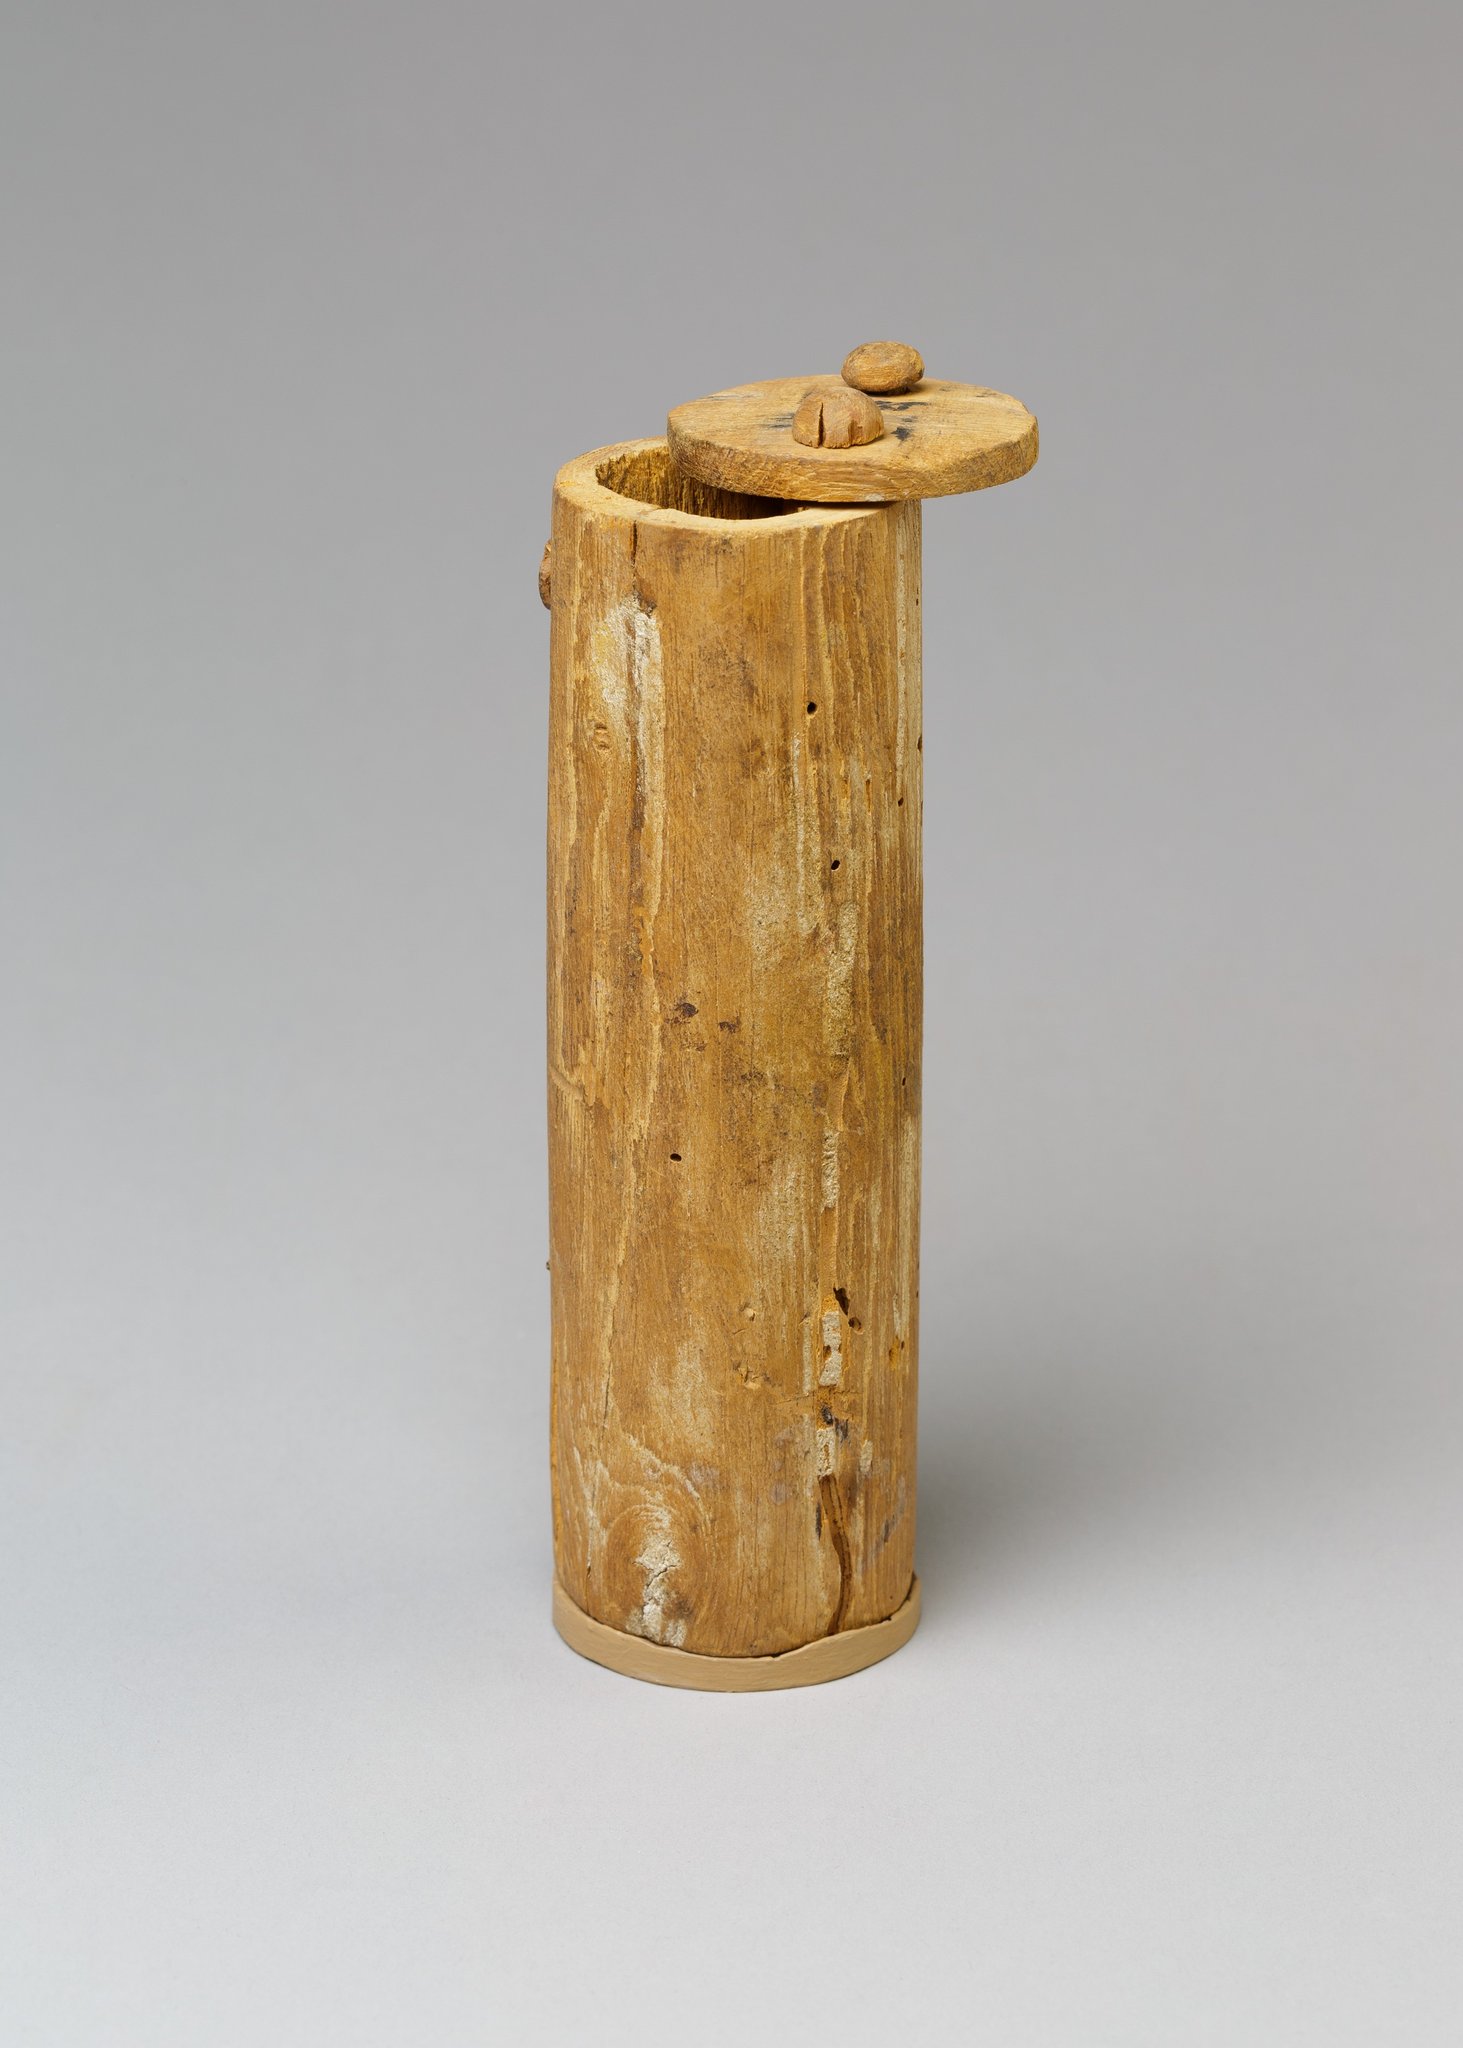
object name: scribe's box, cylindrical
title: Cylindrical Scribe's Box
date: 1479-1458 BCE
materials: wood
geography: egypt